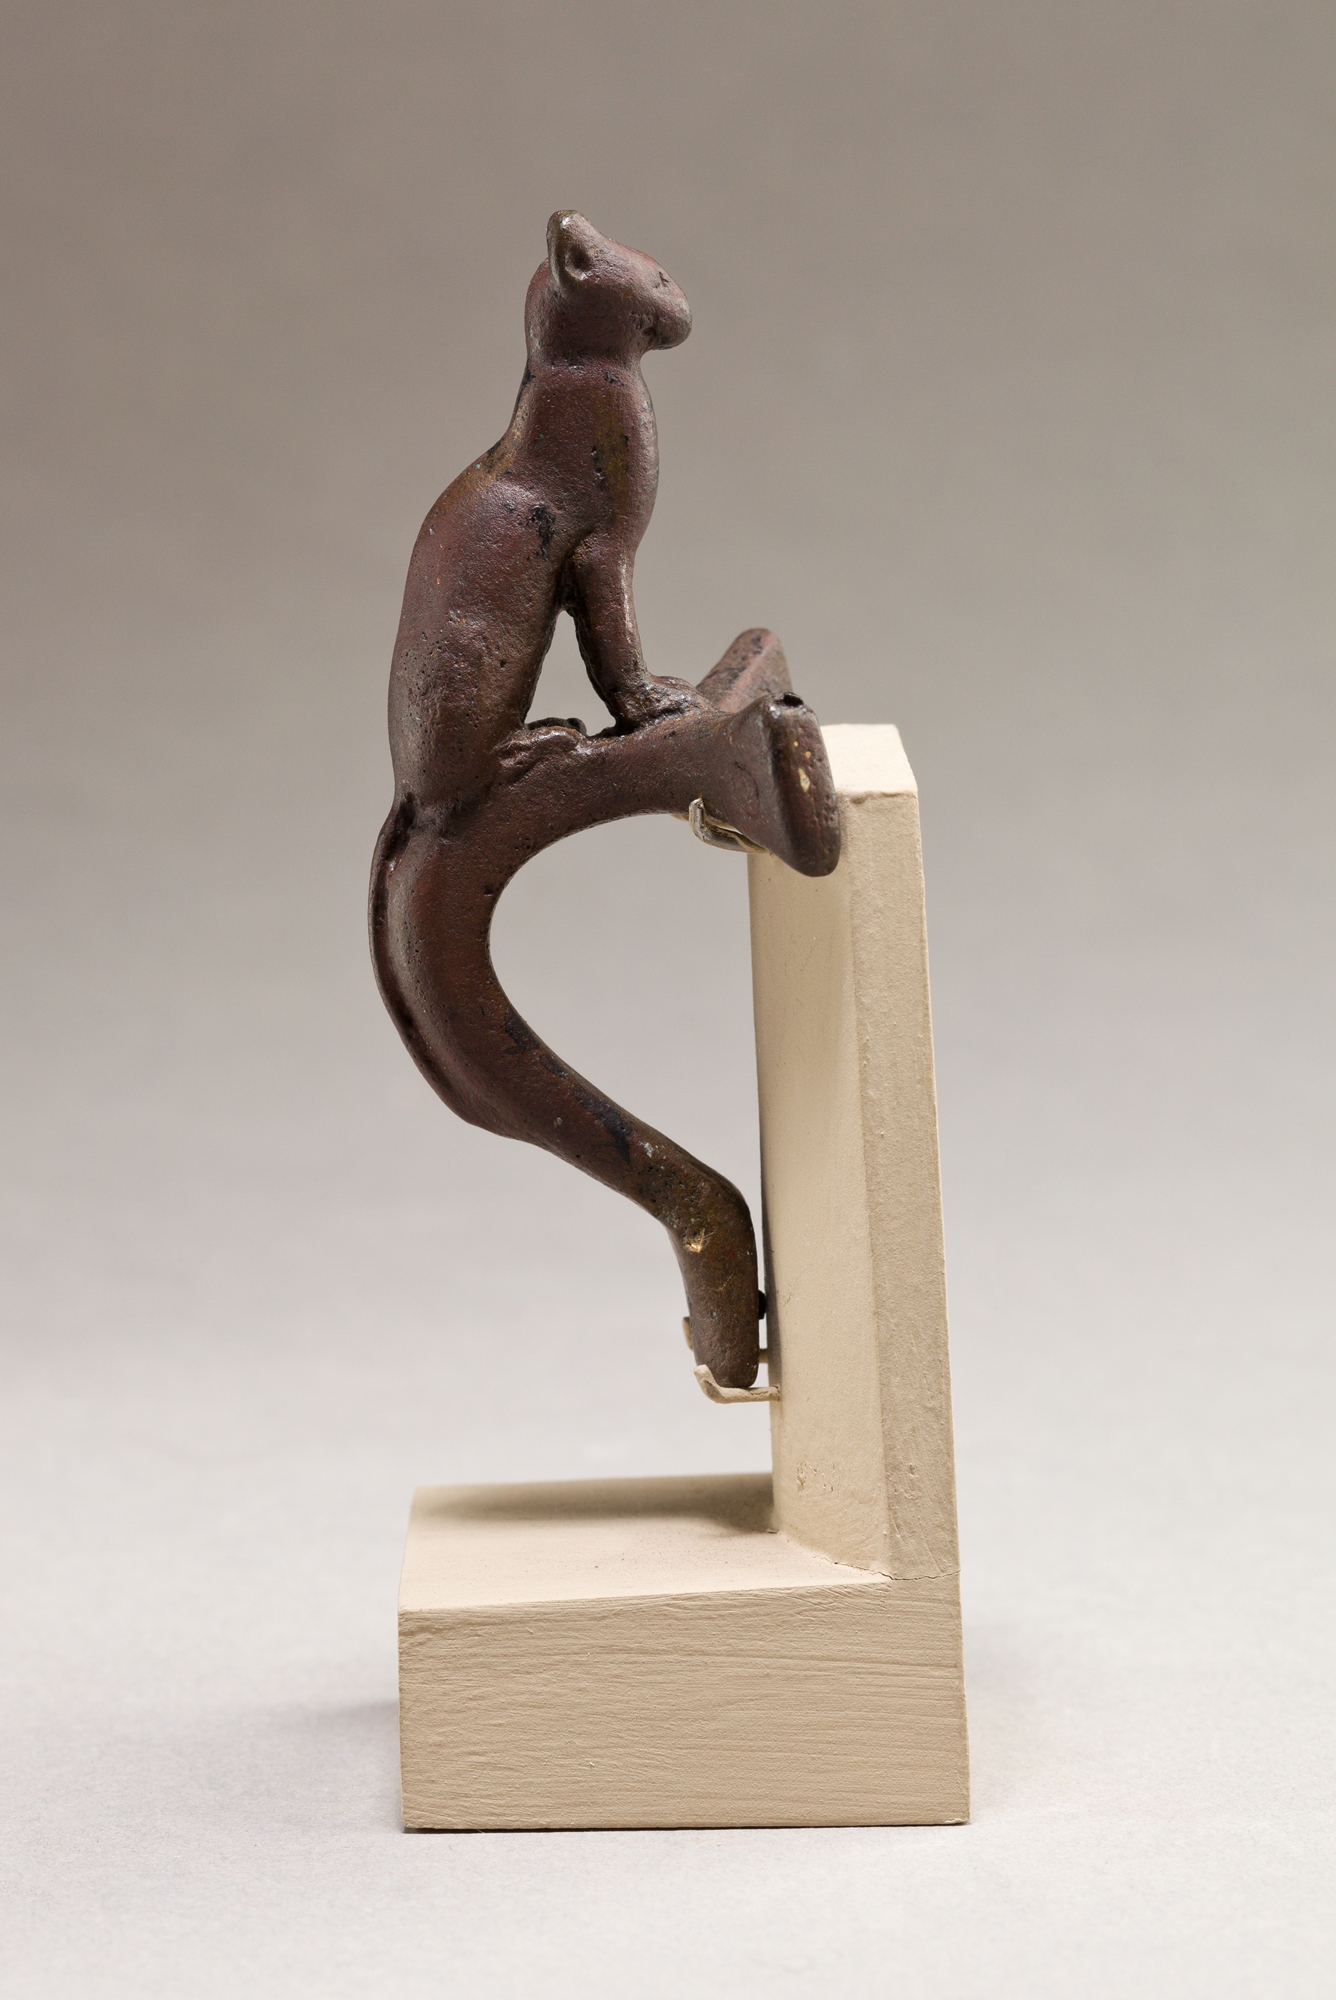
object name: figurine, cat, handle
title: Cat on a handle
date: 664-630 BCE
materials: metal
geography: egypt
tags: cats